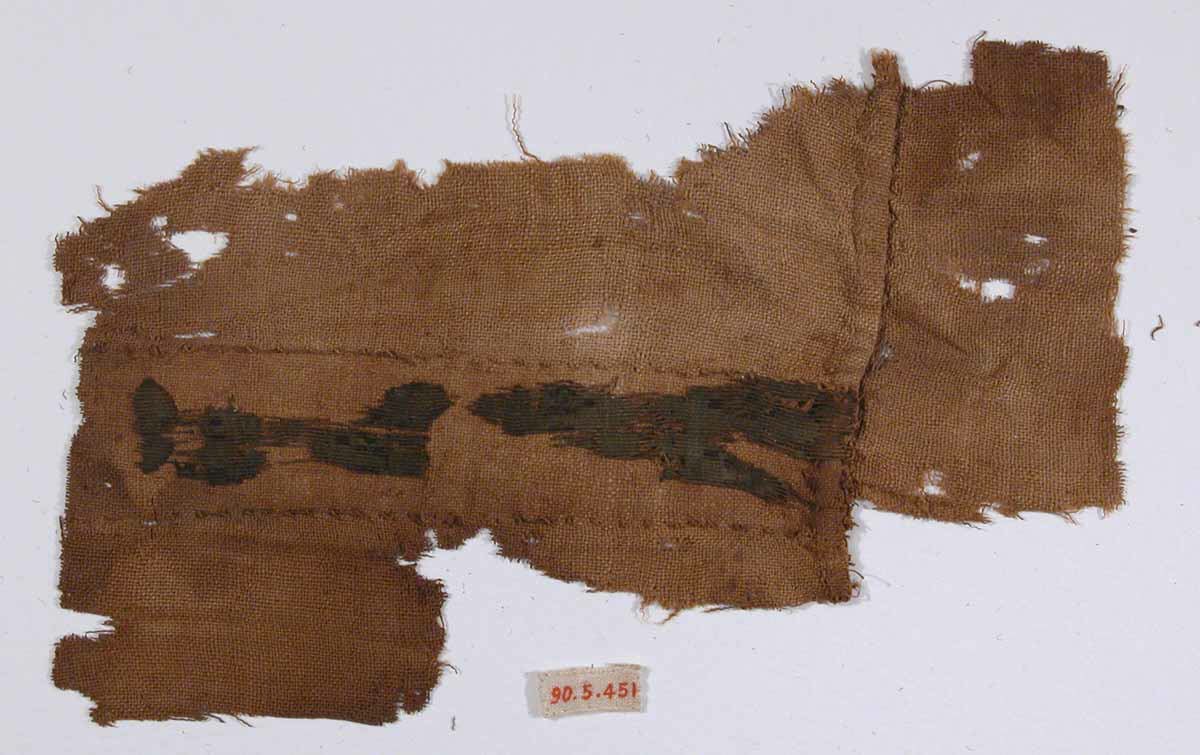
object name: textile fragment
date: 301-500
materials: linen, wool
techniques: weave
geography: egypt